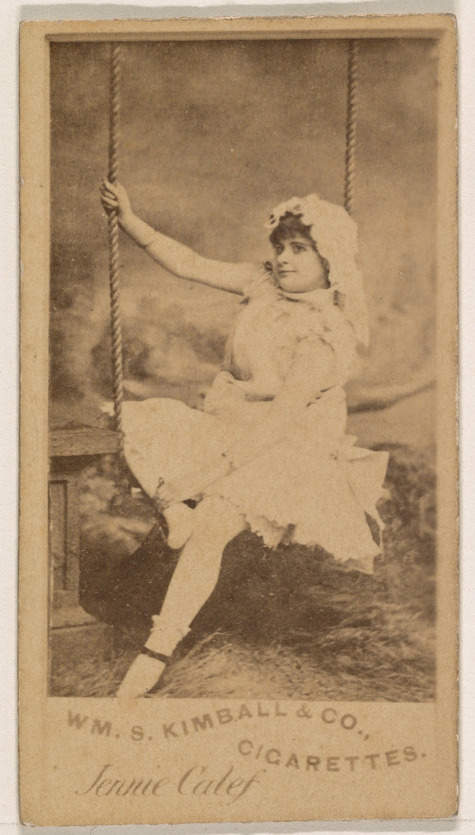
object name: photograph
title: Jennie Calef, from the Actresses series (N203) issued by Wm. S. Kimball & Co.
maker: william s. kimball & company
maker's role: publisher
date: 1889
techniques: color lithograph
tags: portraits,women,actresses